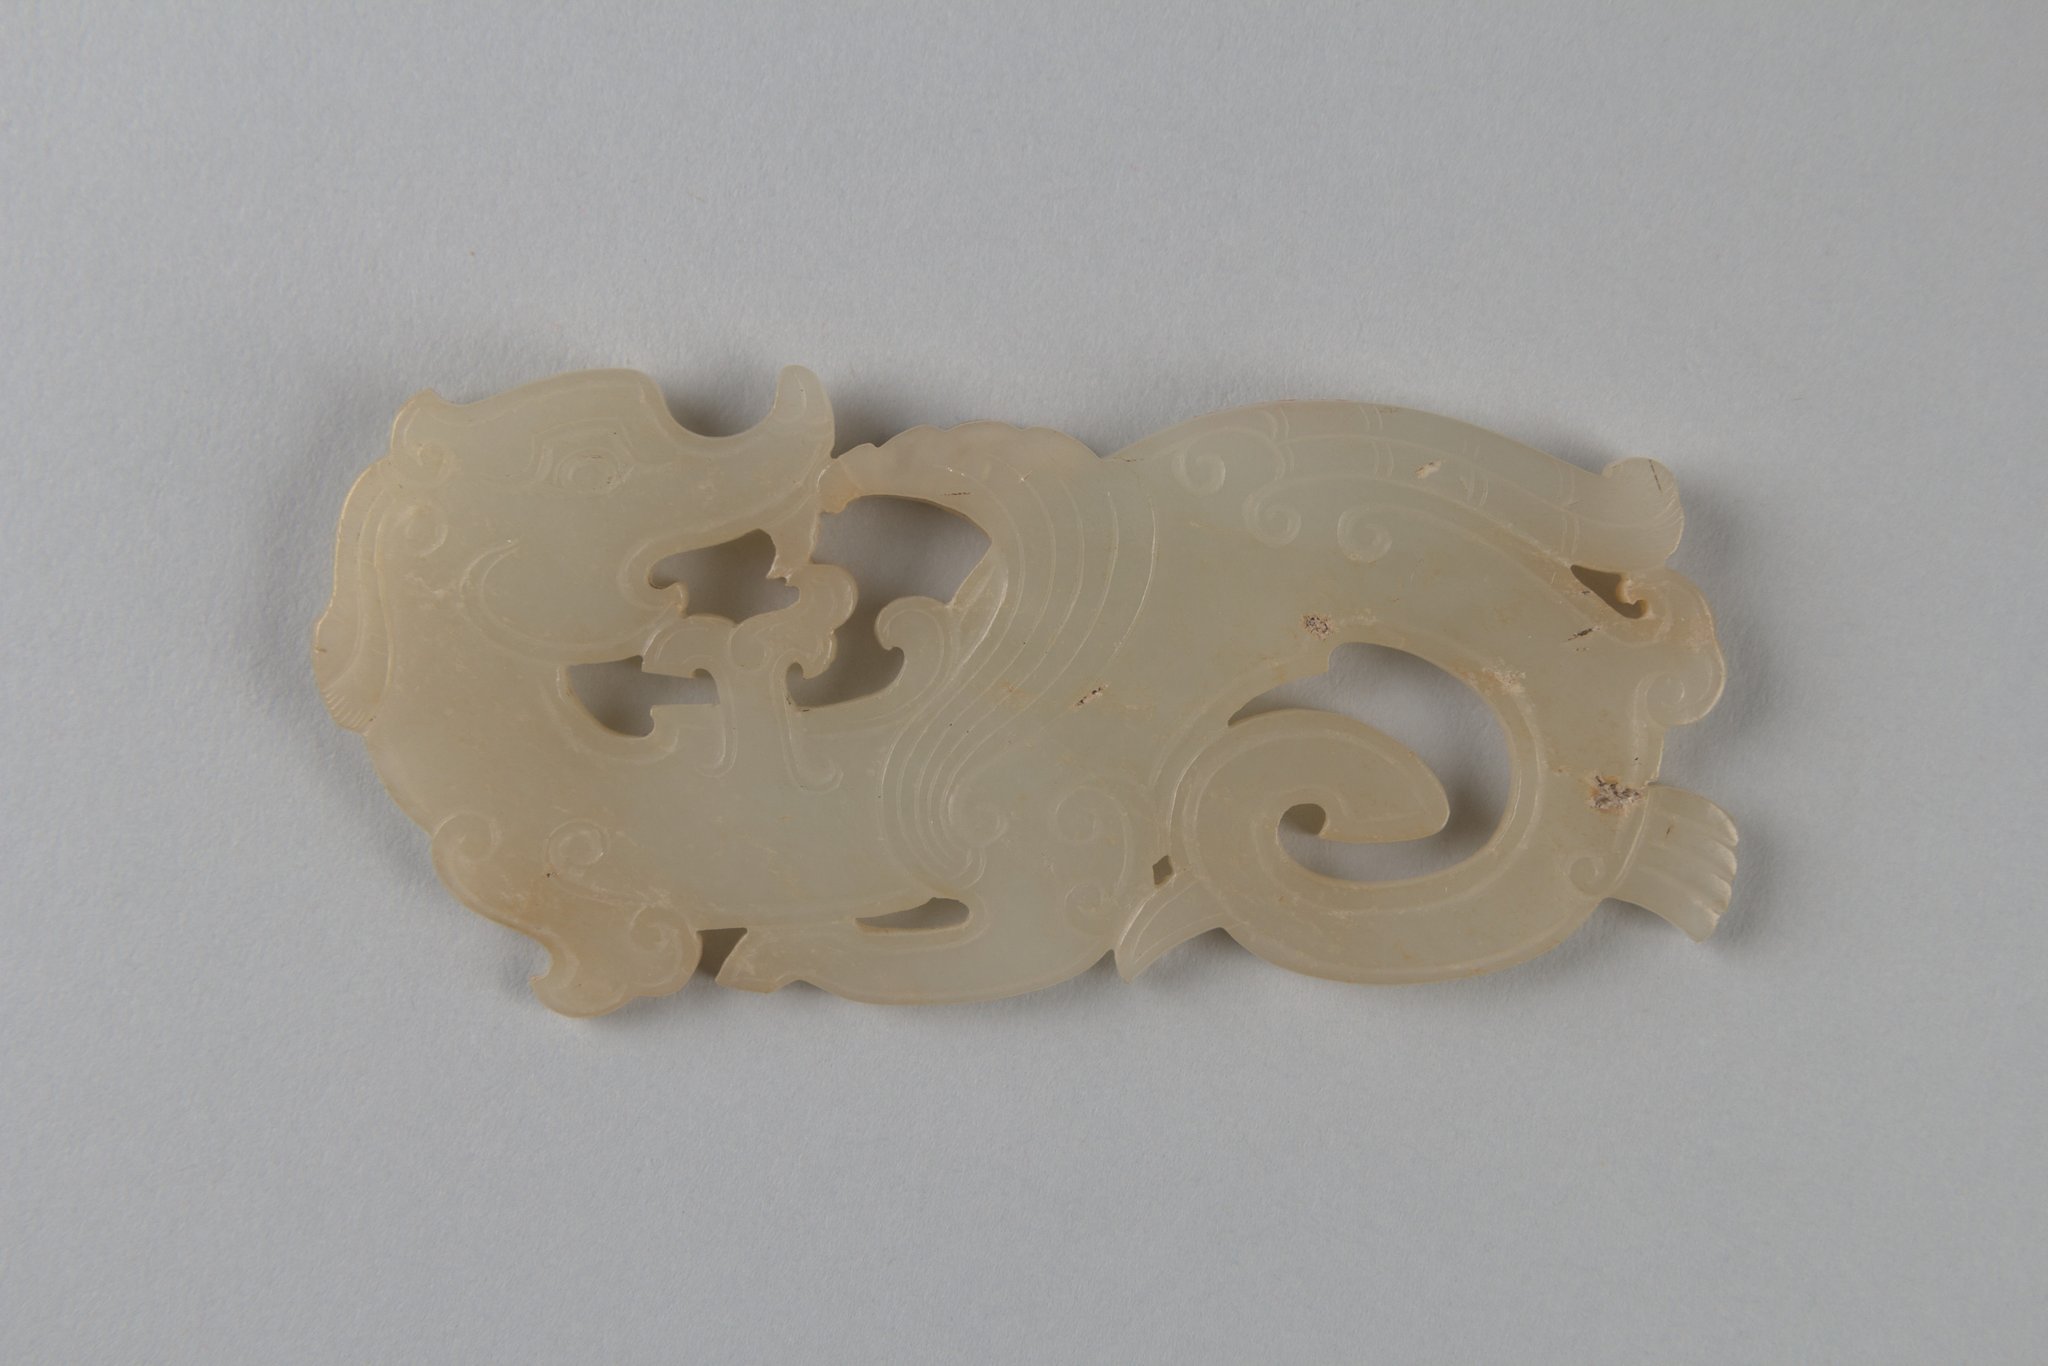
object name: dragon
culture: chinese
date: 1867-1933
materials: jade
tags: dragons